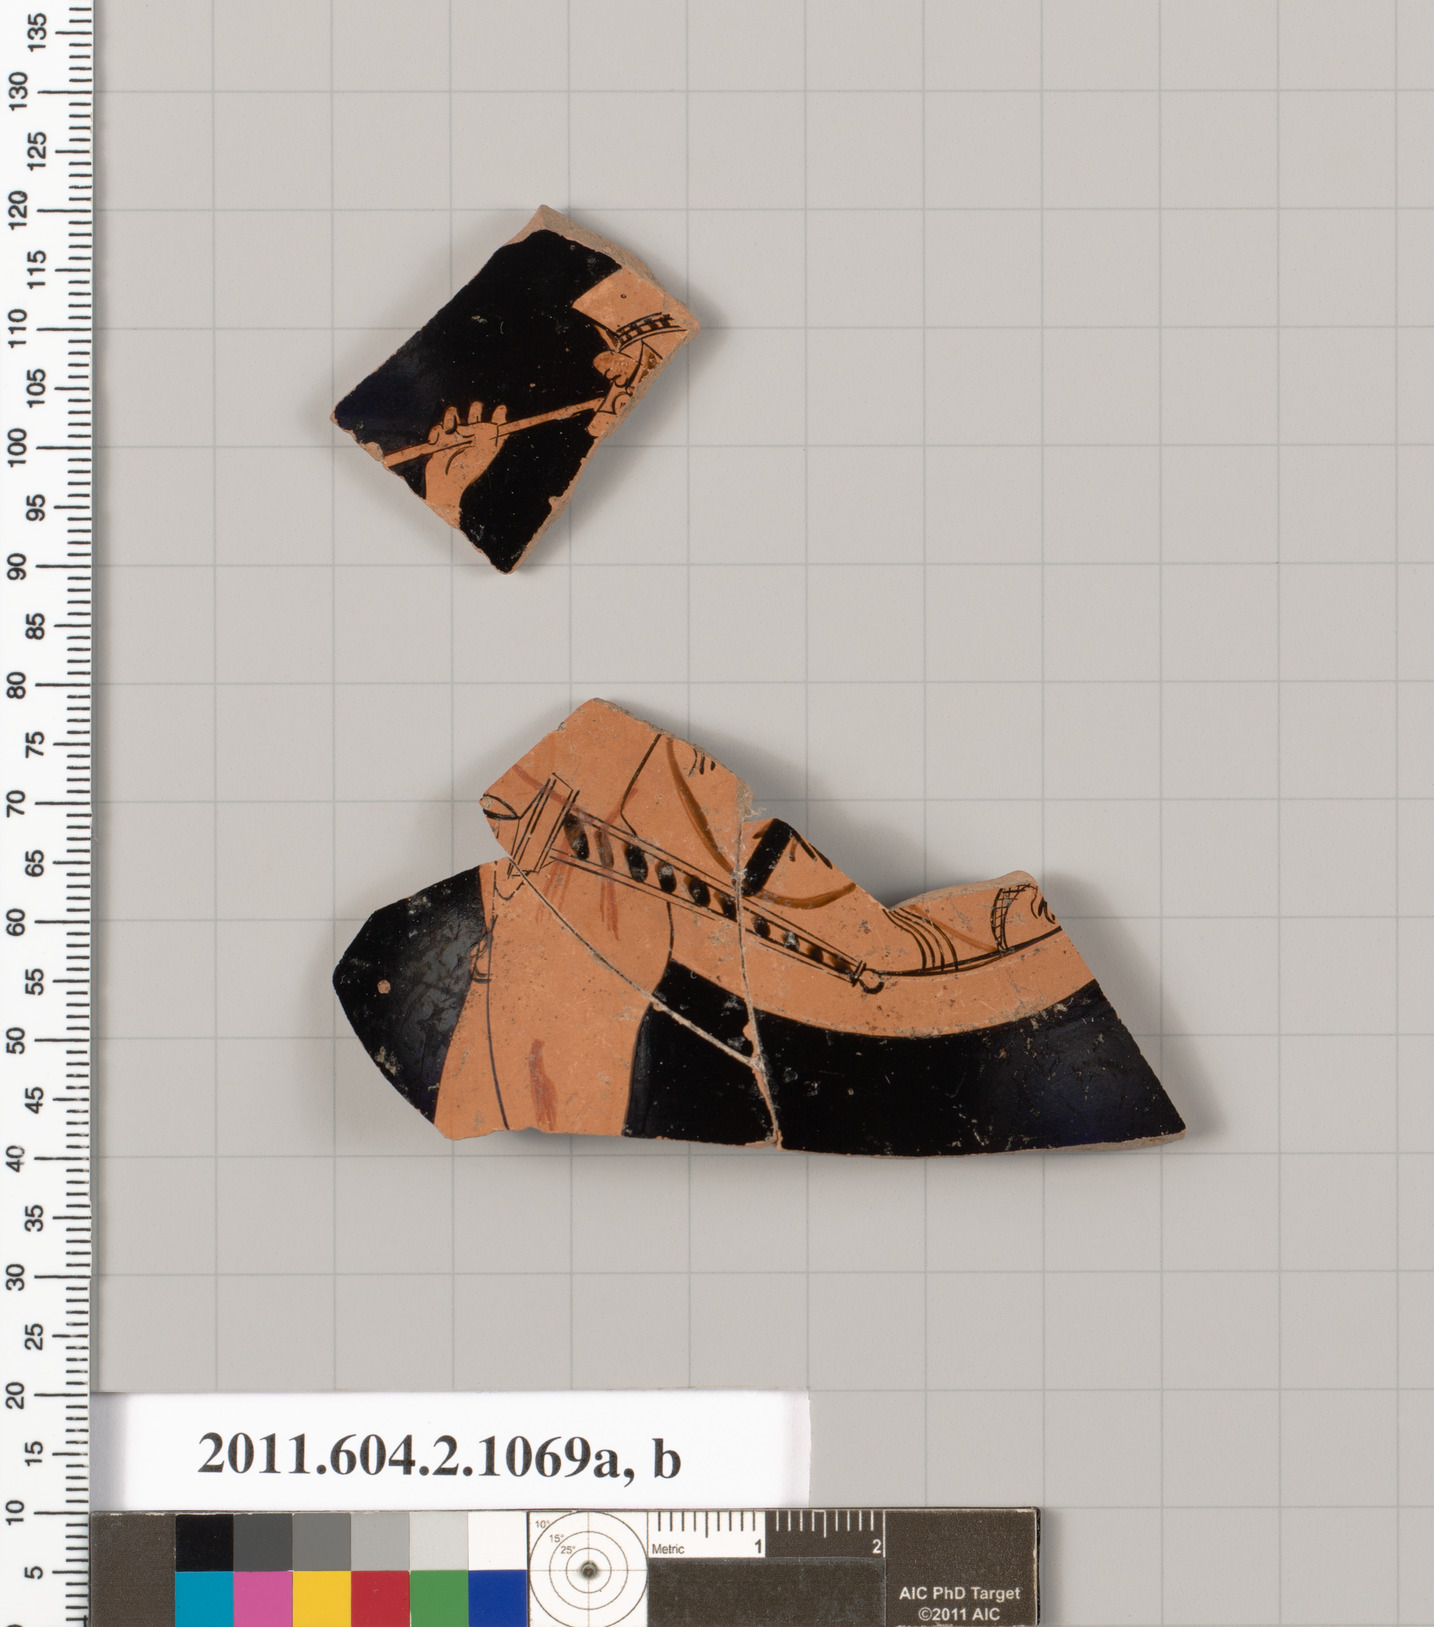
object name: mug, oinochoe, shape 8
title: Terracotta fragments of a mug, oinochoe, shape 8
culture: greek, attic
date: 500-480 BCE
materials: terracotta